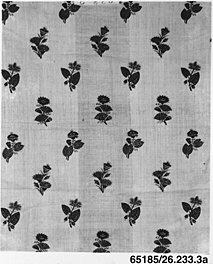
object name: floral print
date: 1775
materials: linen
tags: flowers